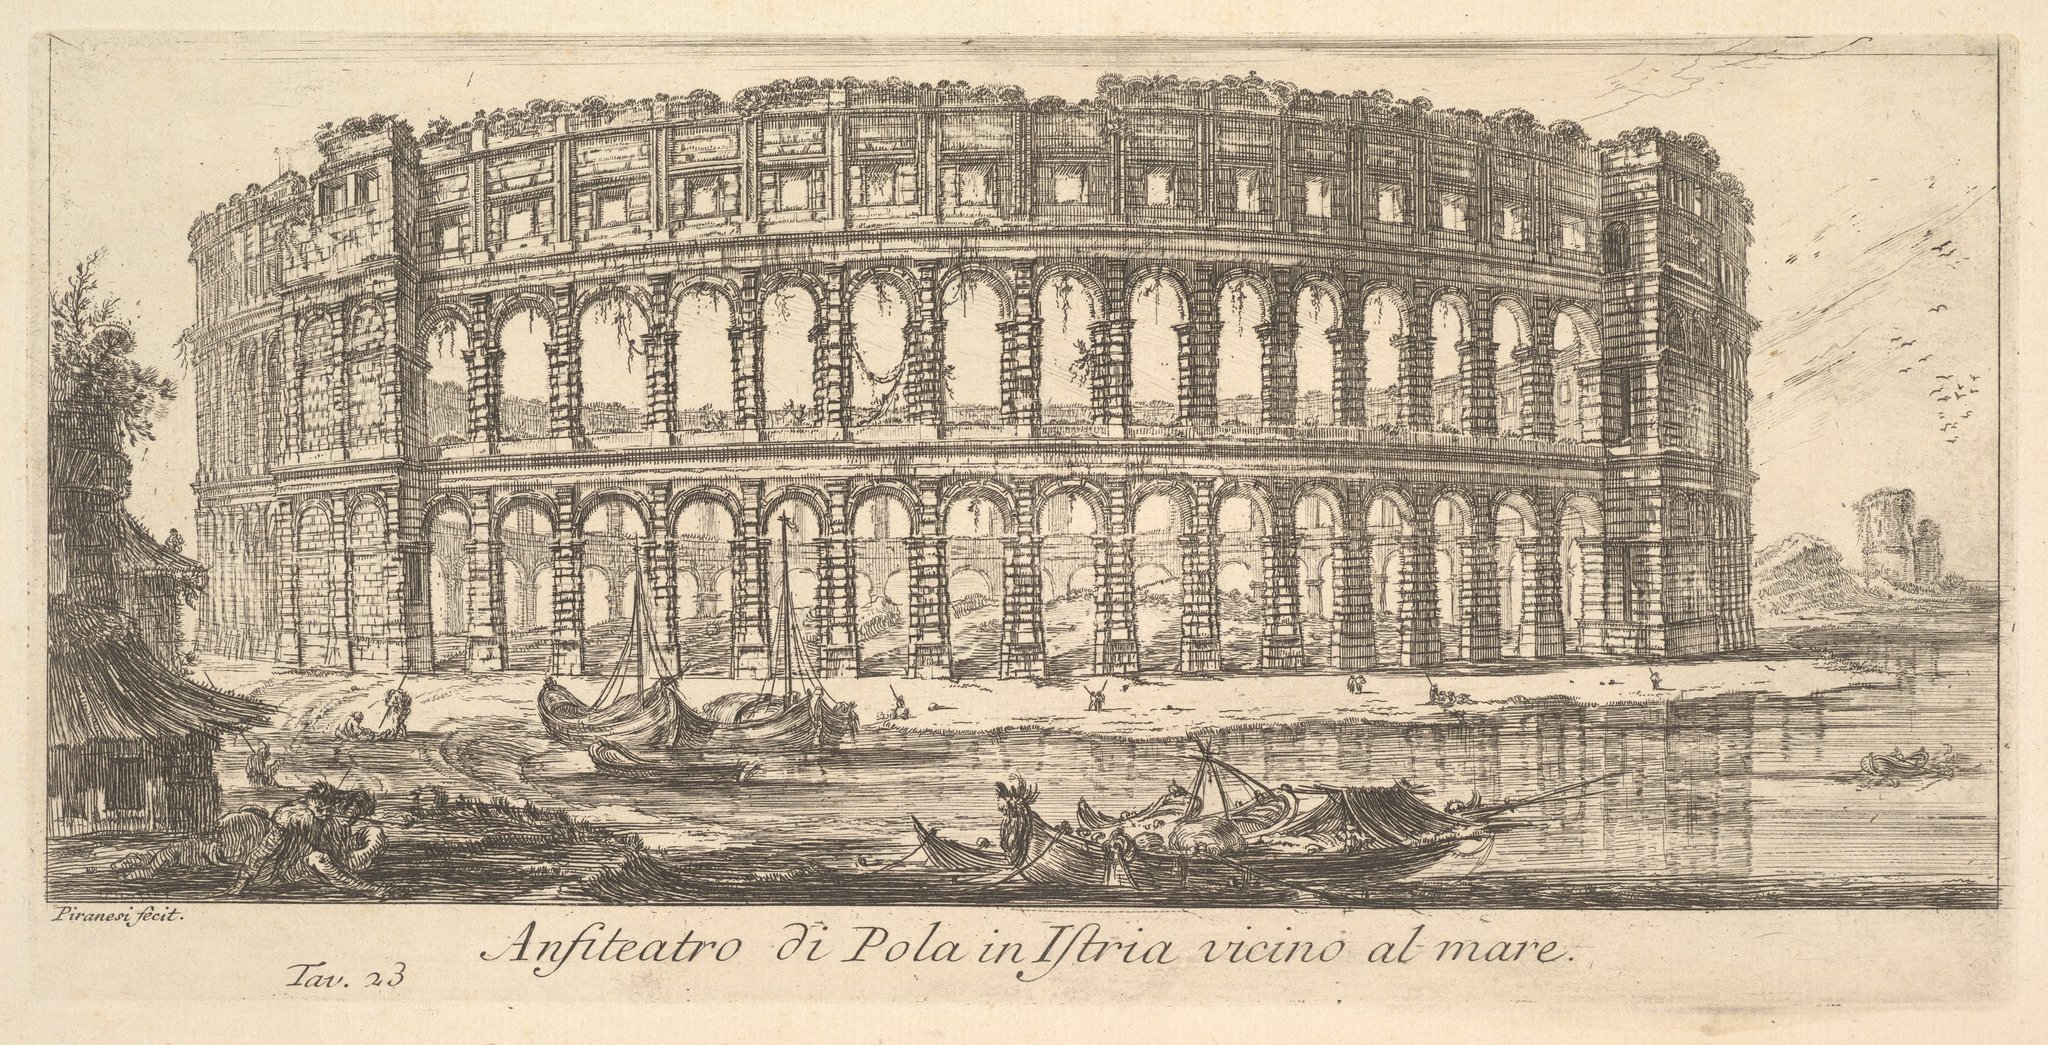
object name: print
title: Plate 23: Amphitheater of Pola in Istria near the sea (Anfiteatro di Pola in Istria vicino al mare), from "Alcune Vedute di Archi Trionfali ed altri monumenti inalzati da Romani parte di quali se veggono in Roma e parte per l'Italia" (Some Views of Triumphal Arches and other monuments erected by the Romans, some of which are in Rome and some elsewhere in Italy)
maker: giovanni battista piranesi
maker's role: artist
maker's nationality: italian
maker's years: 1720-1778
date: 1748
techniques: etching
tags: architecture,buildings,boats